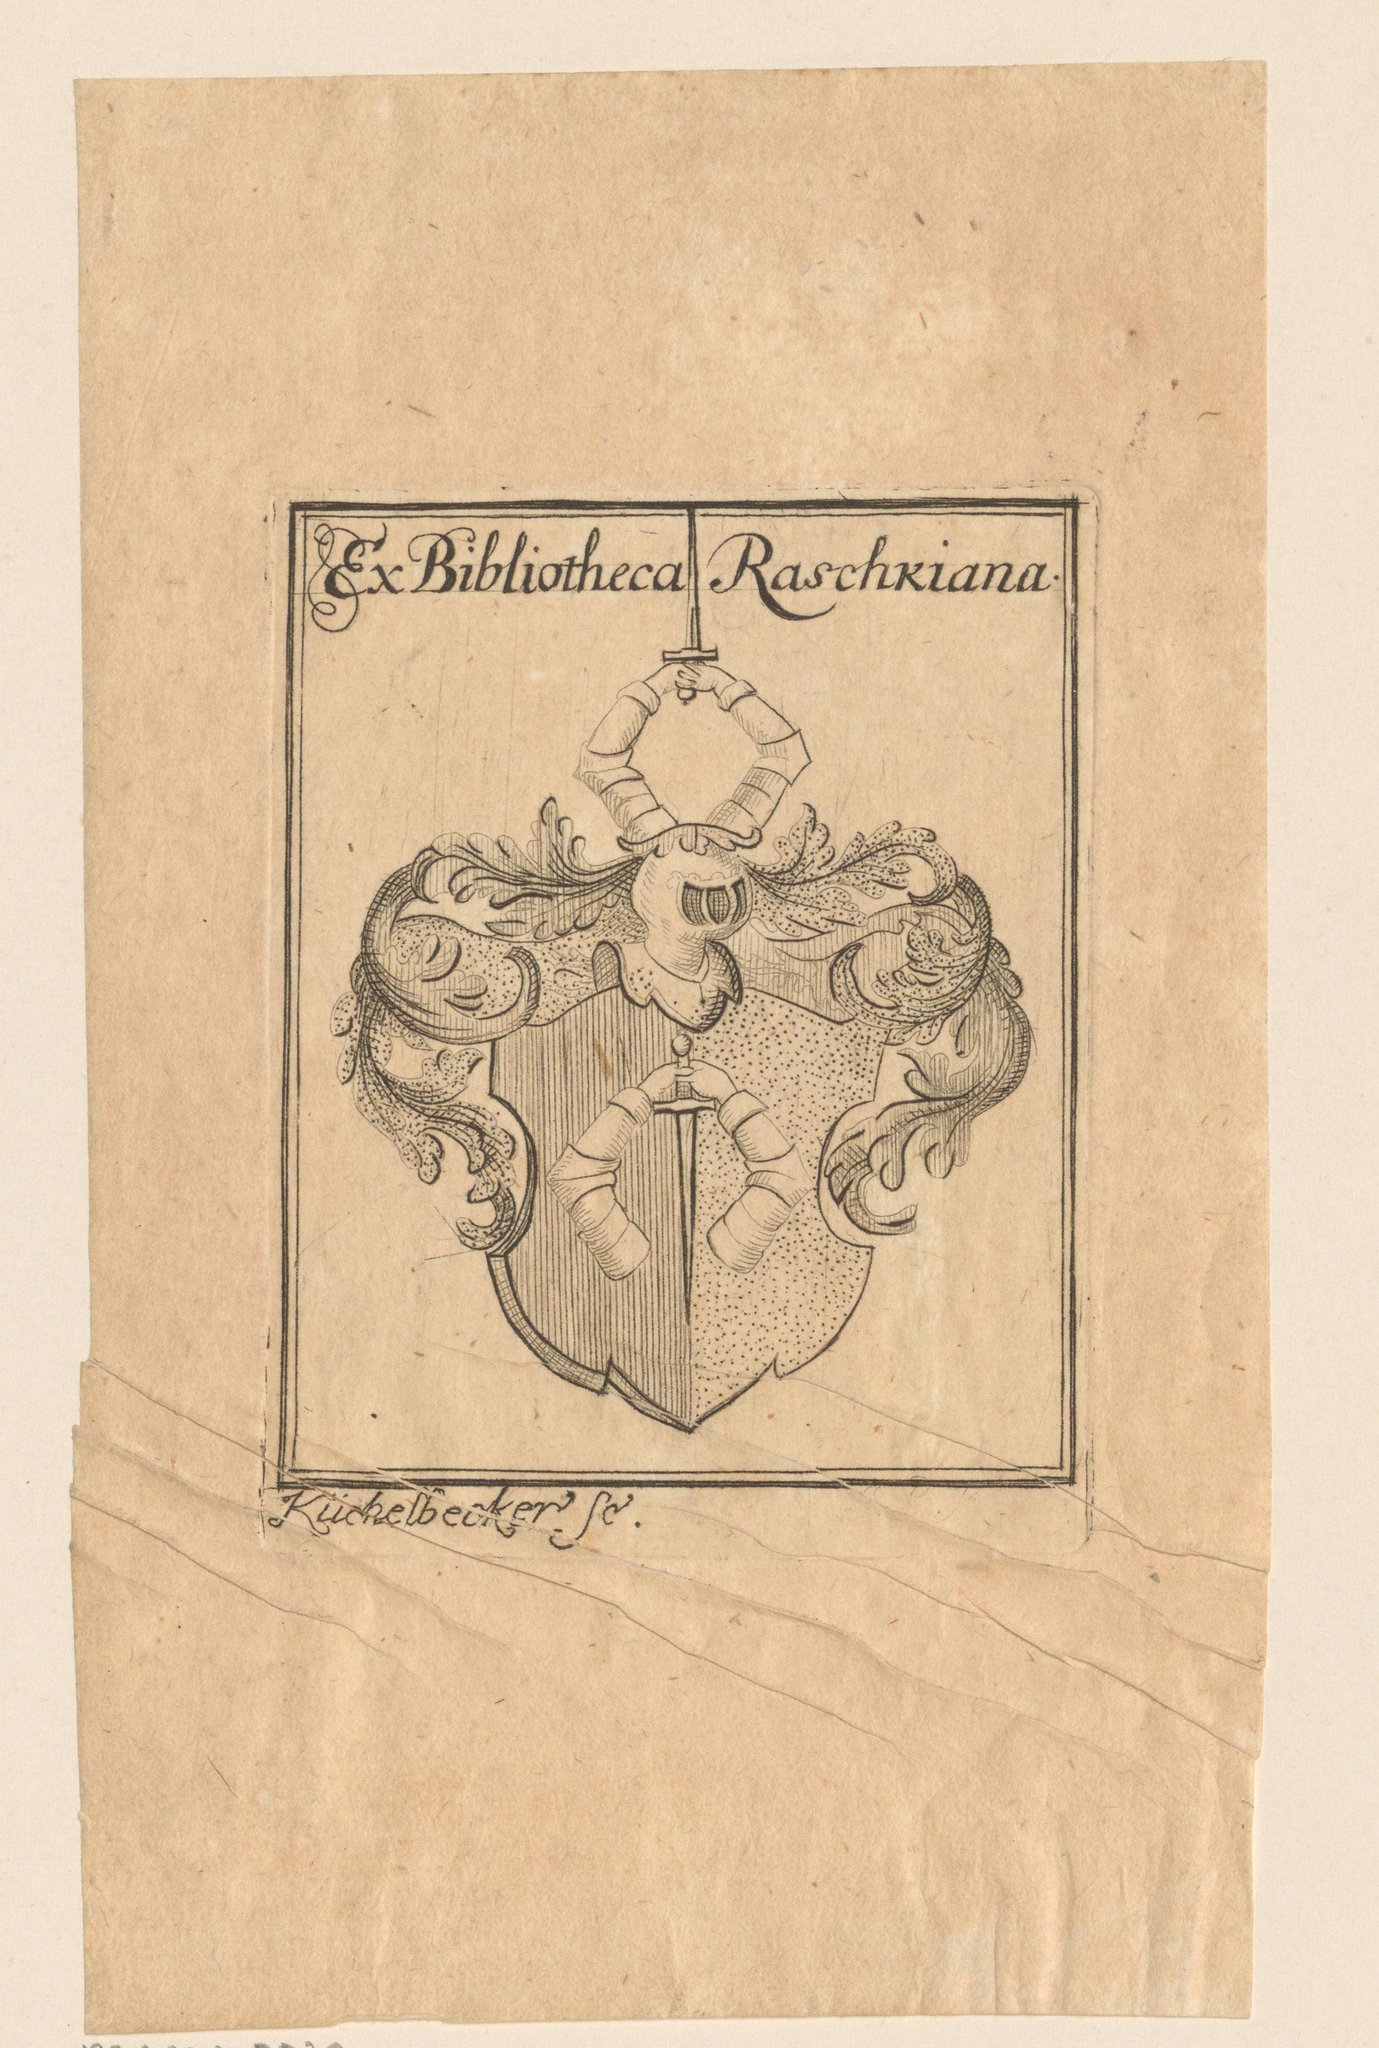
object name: bookplate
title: Ex libris van Raschkia [?]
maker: Anonymous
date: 1750-1849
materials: paper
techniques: etching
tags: hacking and thrusting weapons: sword, armorial bearing, heraldry